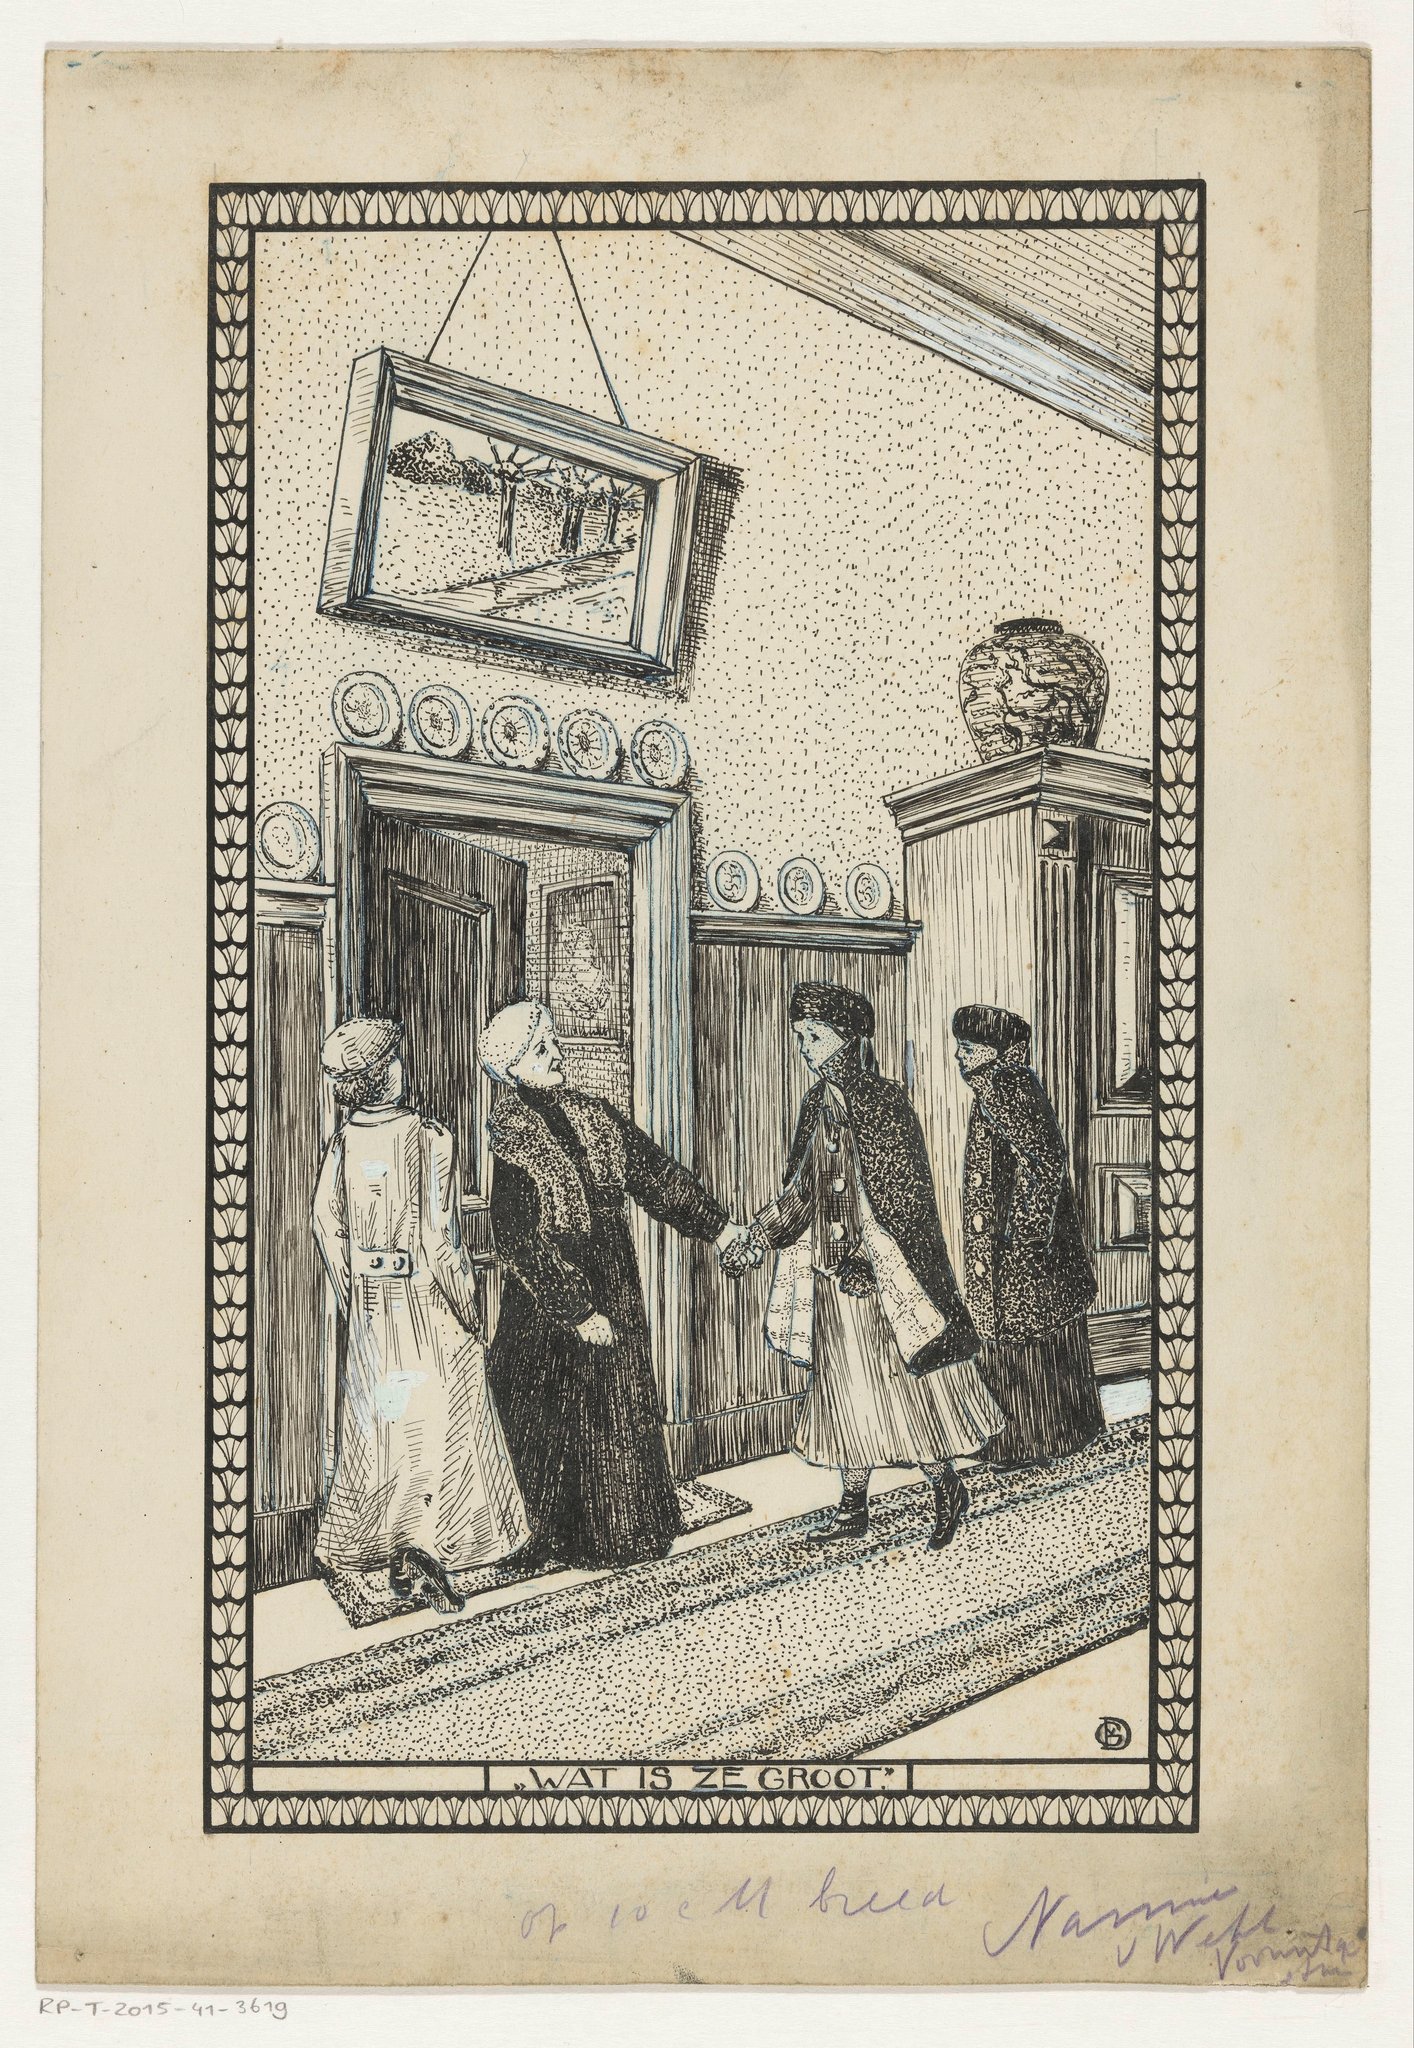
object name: drawing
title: "WAT IS ZE GROOT."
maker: g. van doorn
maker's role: illustrator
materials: paint, ink, paper, pencil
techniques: brush, pen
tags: corridor, grandparent(s) with grandchild(ren) (family group)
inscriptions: annotation: ‘Nannie/ v Wehl/ Vooruitge/ stuurd’, collector's mark: Lugt 2228a, :, monogram: ‘GvD’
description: Grootmoeder staat in de deuropening van een kamer in een hal en bekijkt Frida terwijl ze haar hand vasthoudt. Frida draagt een mantel, wanten en muts. In de hal staan nog twee personen.